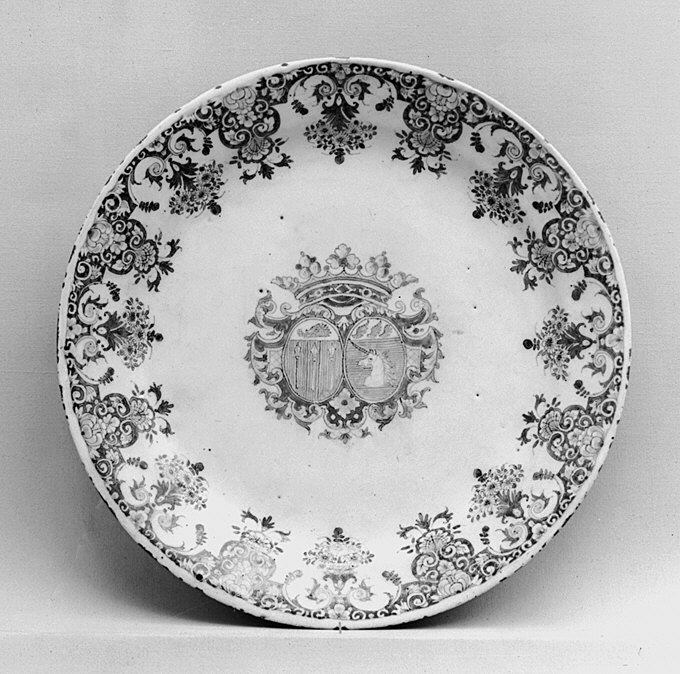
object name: plate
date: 1720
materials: faience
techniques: glazing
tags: flowers,coat of arms